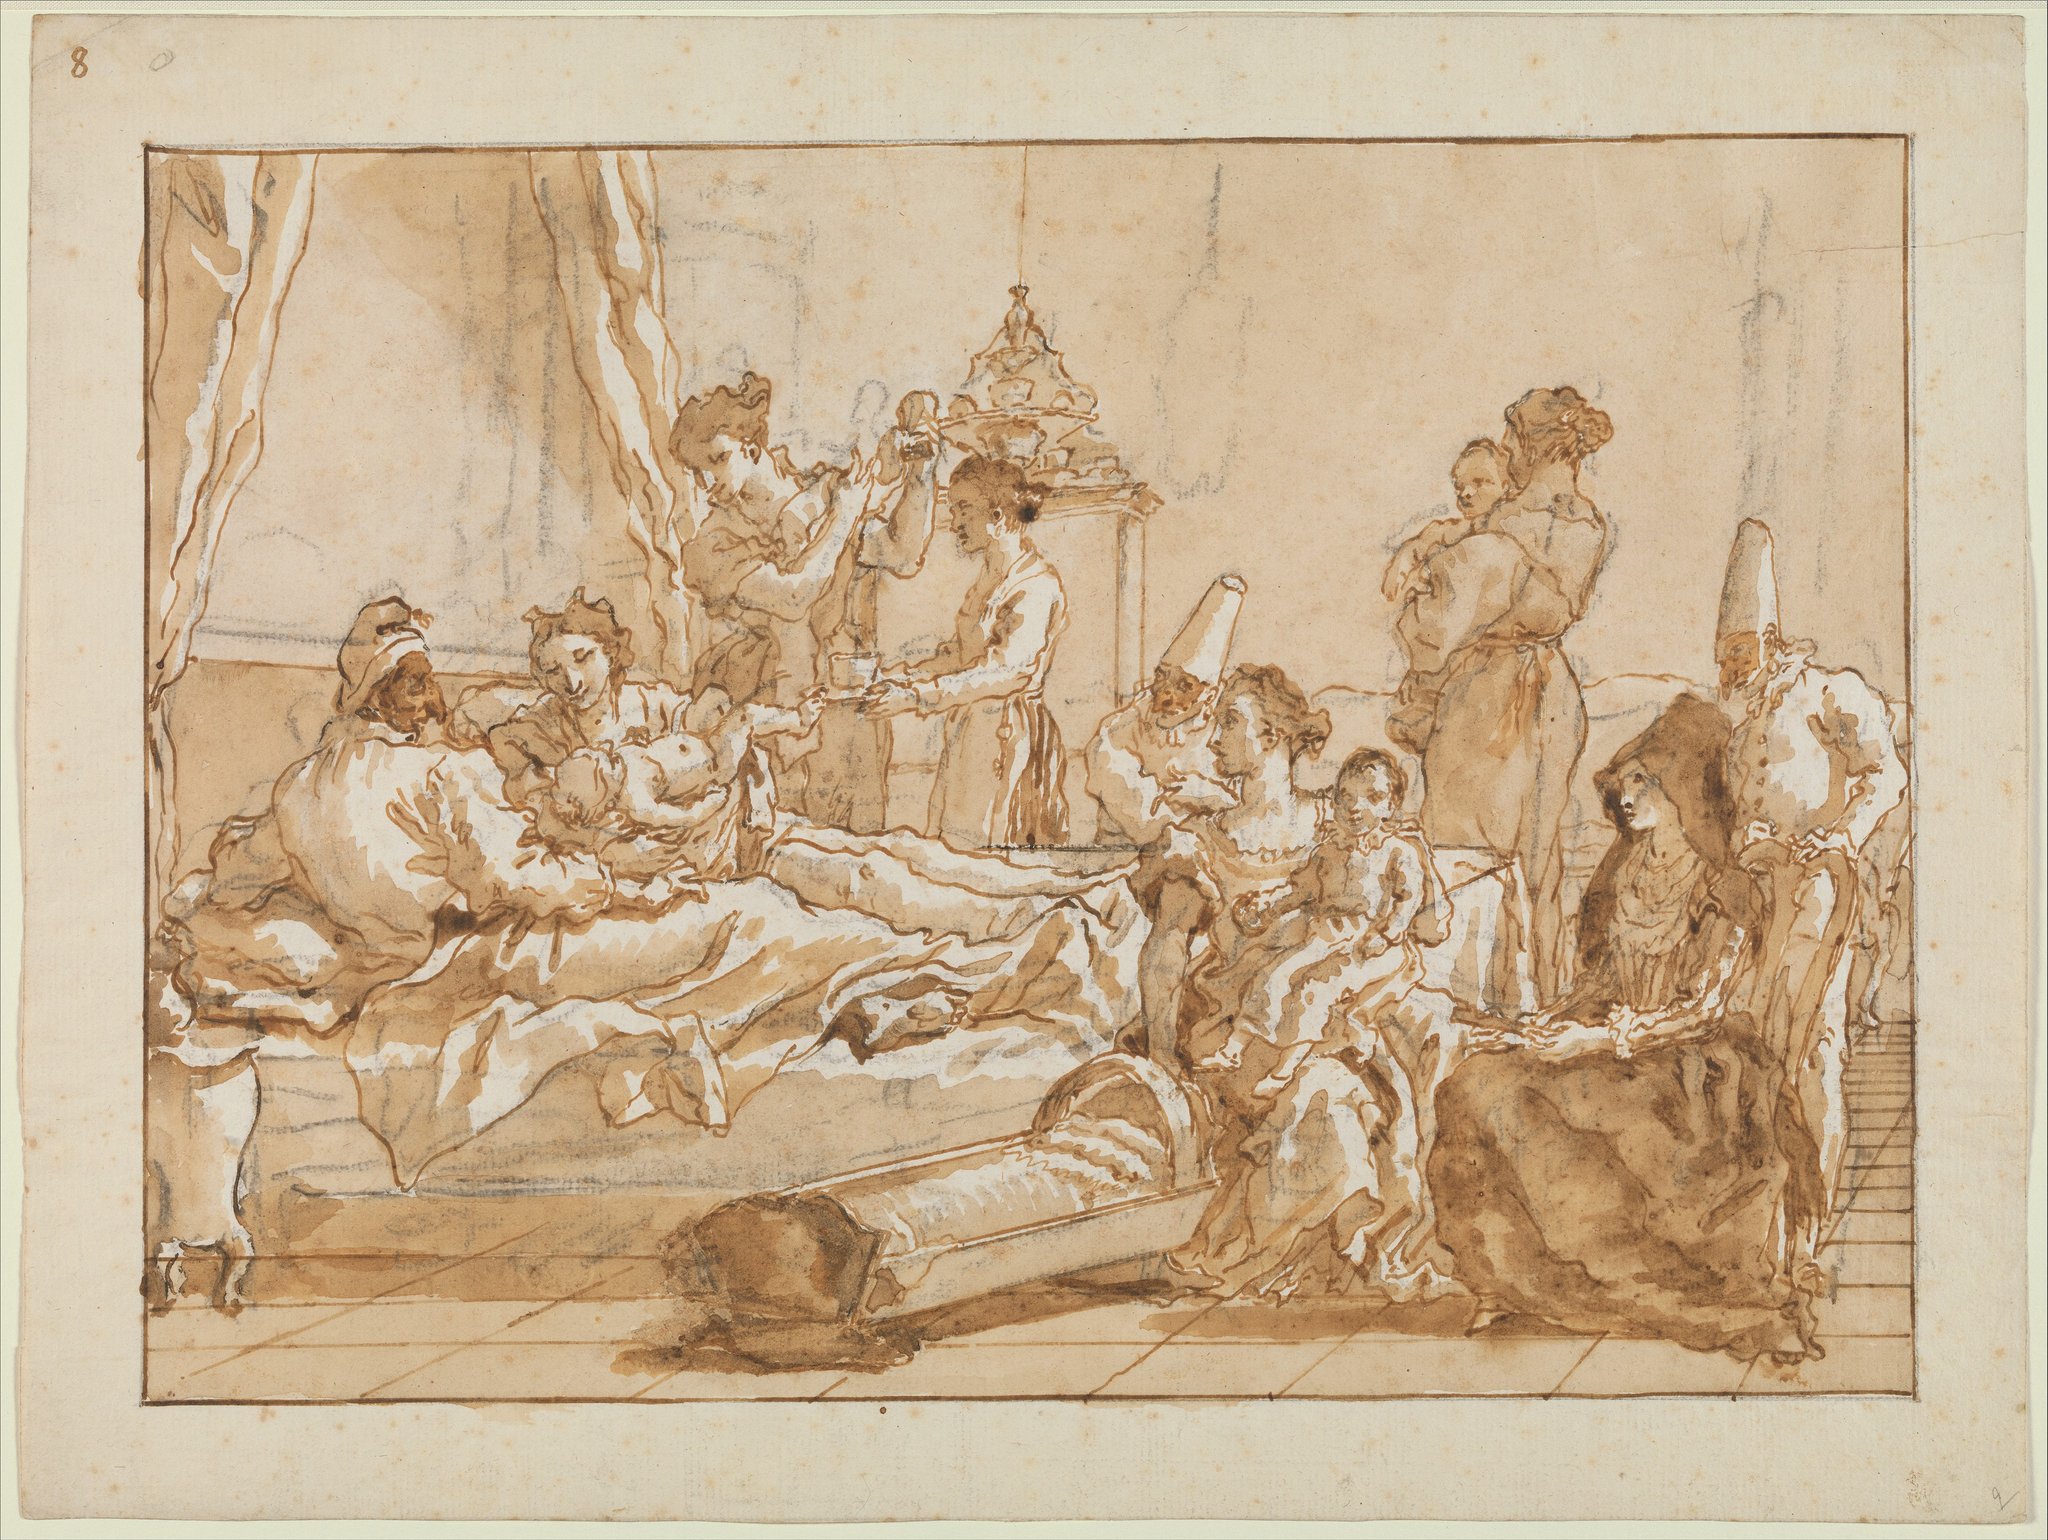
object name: drawing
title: The Infant Punchinello in Bed with His Parents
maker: giovanni domenico tiepolo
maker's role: artist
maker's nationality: italian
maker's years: 1727-1804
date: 1767-1833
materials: chalk, ink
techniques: pen, wash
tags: infants,fathers,mothers,beds,cradles